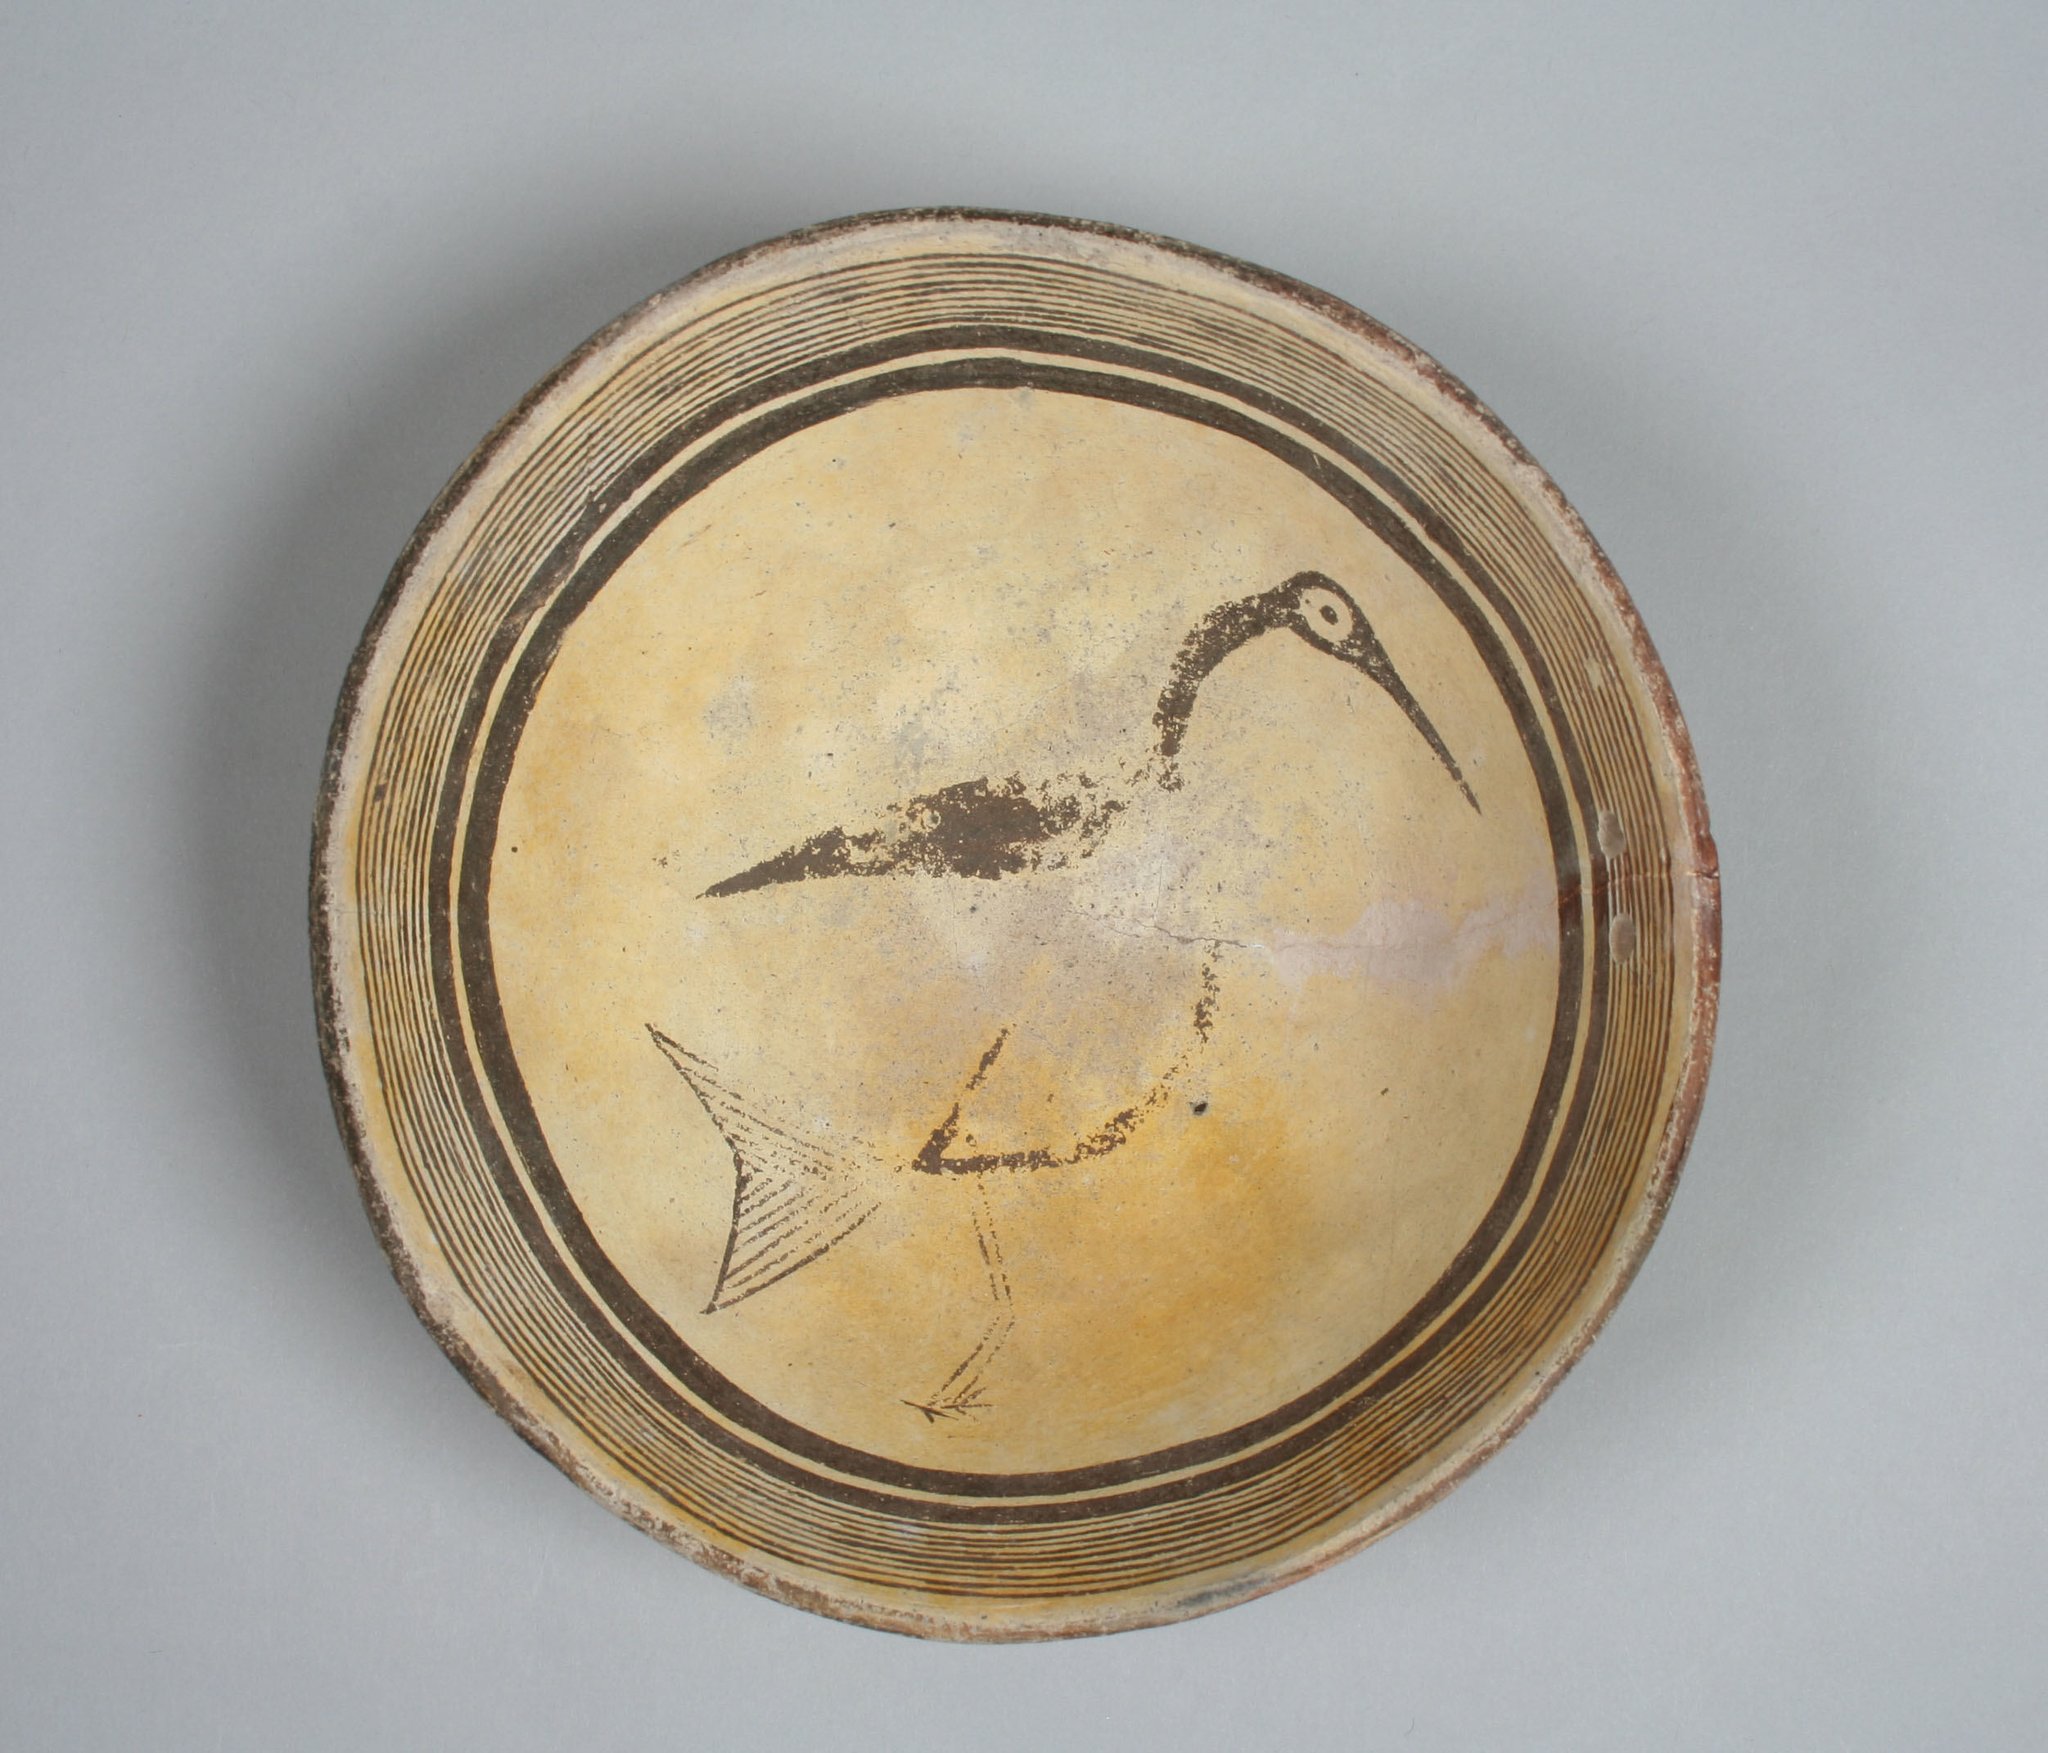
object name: bowl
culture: mimbres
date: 901-1200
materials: ceramic, pigment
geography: united states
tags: birds